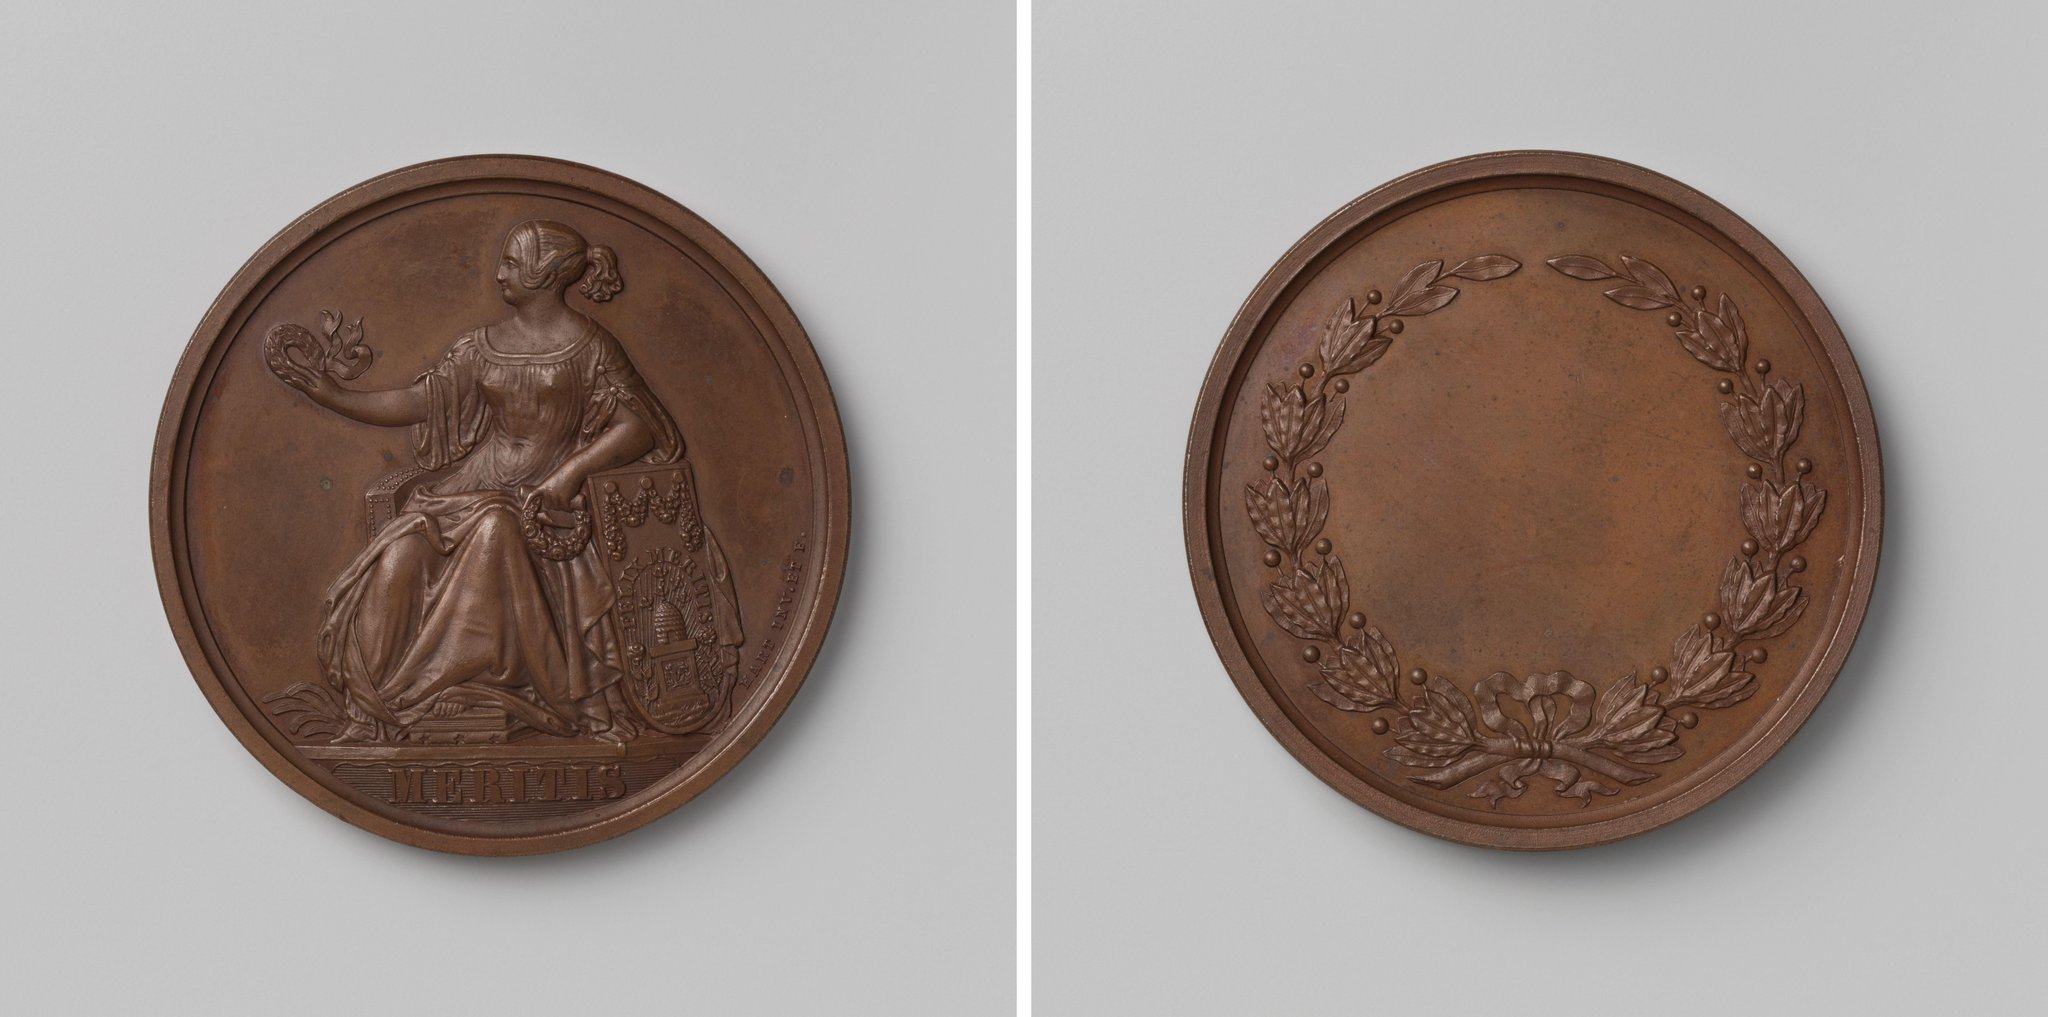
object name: medal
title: Maatschappij "Felix Meritis"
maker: laurent joseph hart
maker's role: die cutter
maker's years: 1810-1860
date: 1839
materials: bronze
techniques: striking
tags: amsterdam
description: Bronzen penning. Voorzijde: vrouw zittend op troon waartegen wapenschild staat houdt in haar linkerhand krans van rozen en in haar uitgestrekte rechterhand een lauwerkrans; afsnede: opschrift. Keerzijde: blanco veld binnen krans van olijftakken